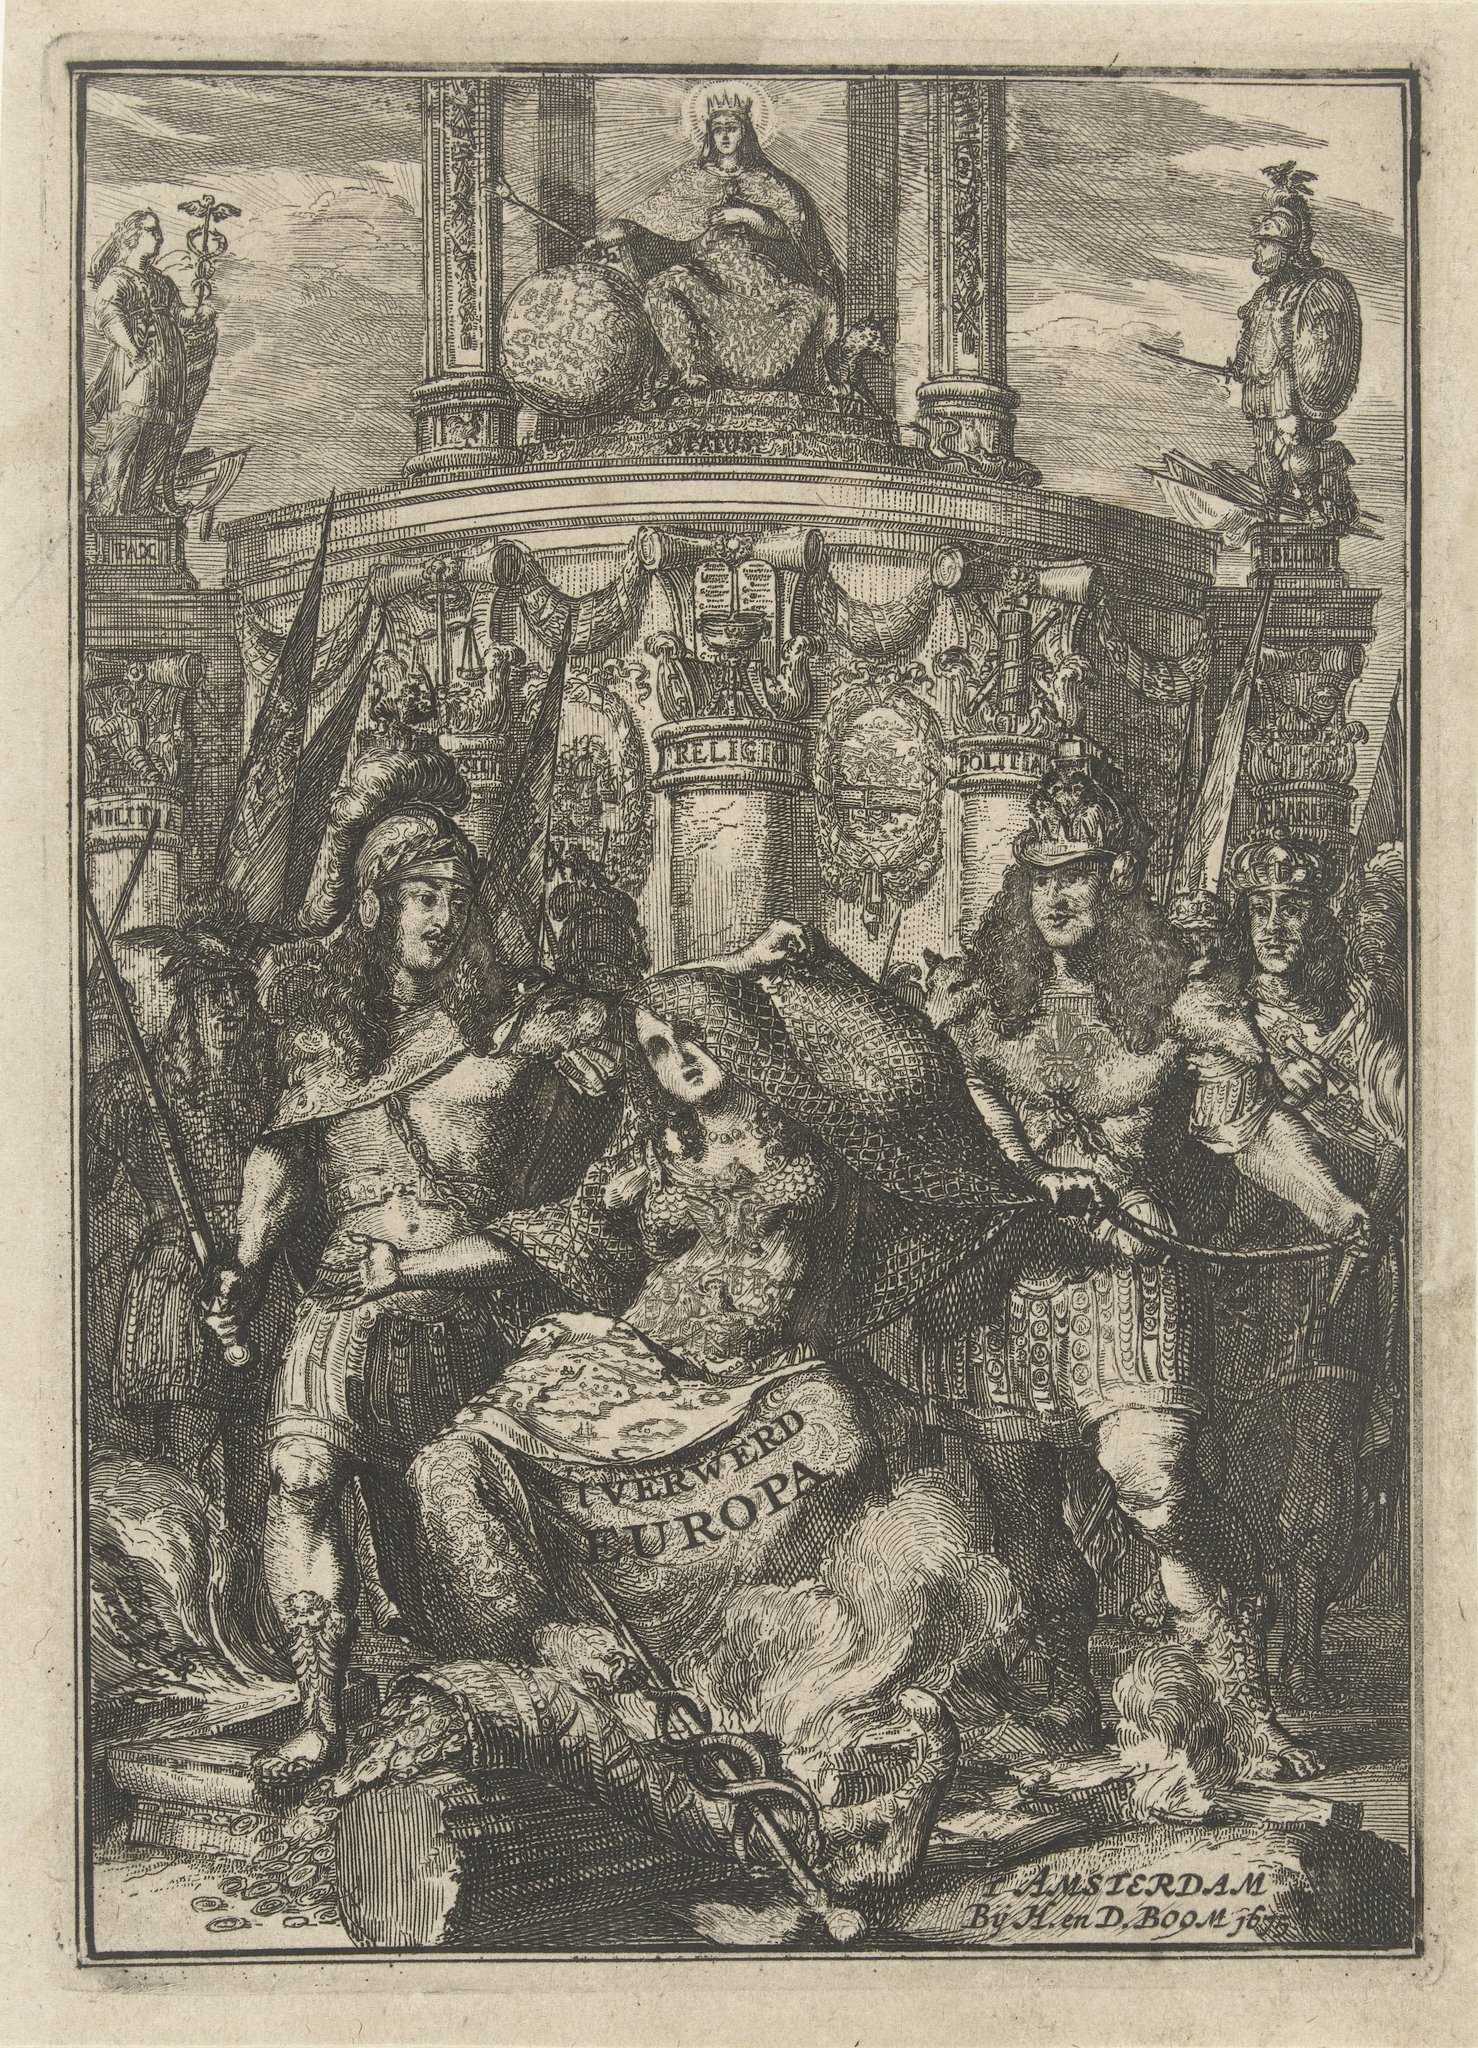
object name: print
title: Titelpagina voor: 't Verwerd Europa, ofte Politijke en historische beschryvinge der waare fundamenten (...) van de oorlogen (...) in Europa, Amsterdam 1675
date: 1675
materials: paper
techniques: etching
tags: europe represented allegorically; 'europa' (ripa)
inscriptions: collector's mark: Lugt 2228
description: Titelpagina voor: Petrus Valkenier, 't Verwerd Europa, ofte Politijke en historische beschryvinge der waare fundamenten (...) van de oorlogen (...) in Europa, Amsterdam, H. en D. Boom (uitgevers) 1675